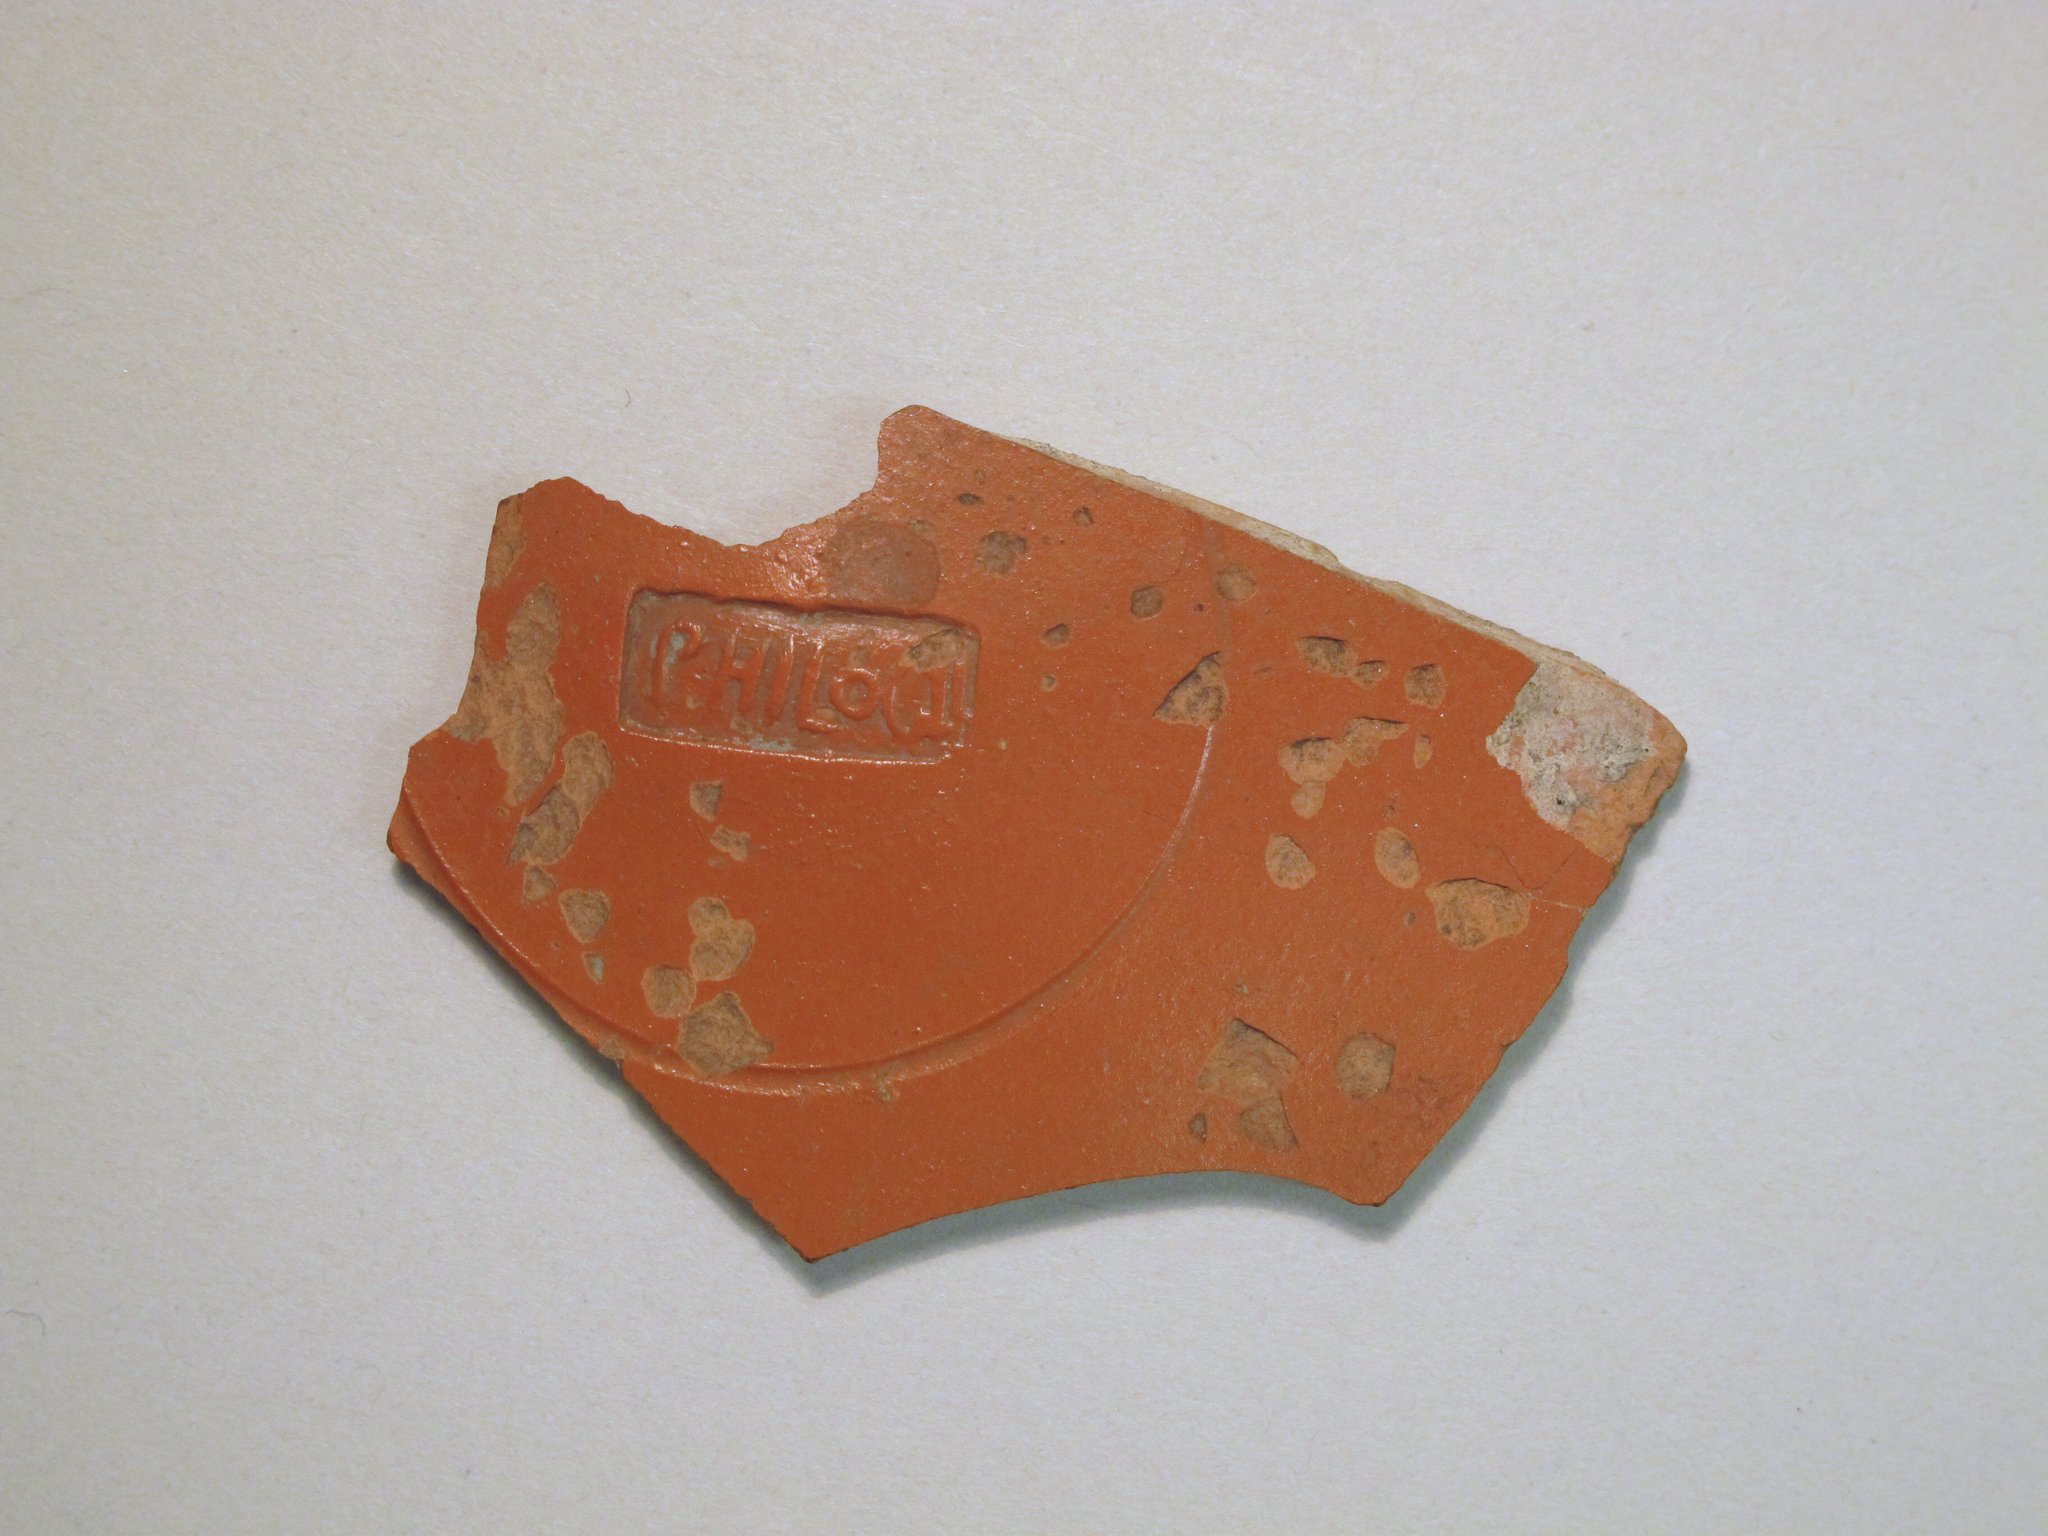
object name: vase fragment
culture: roman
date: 100 BCE-100 CE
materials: terracotta